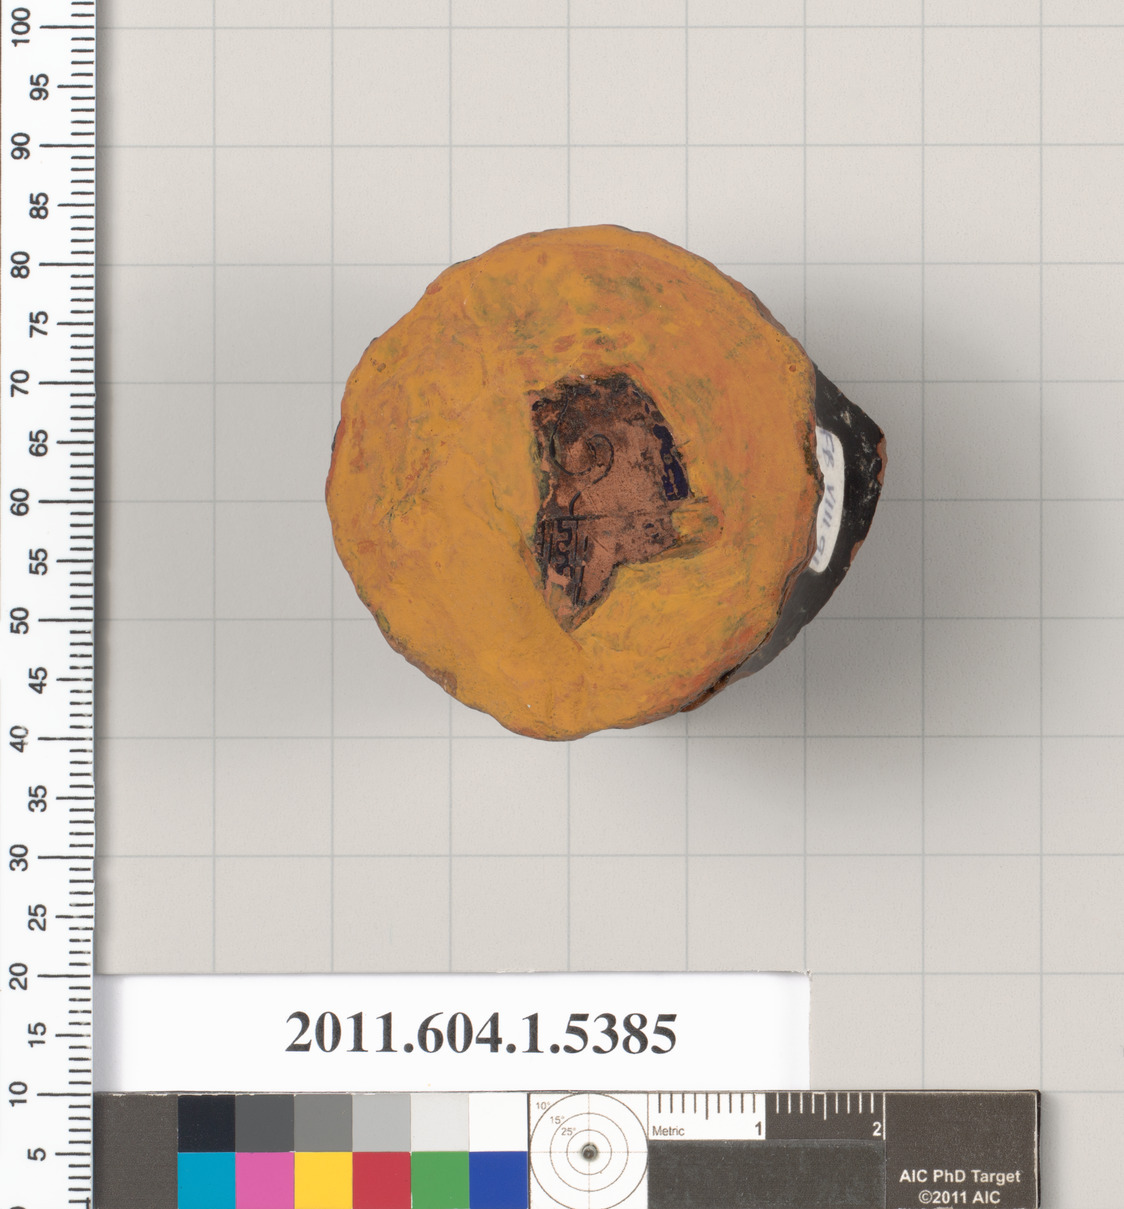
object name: kylix fragment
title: Terracotta fragment of a kylix (drinking cup)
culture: greek, attic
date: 500-490 BCE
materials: terracotta